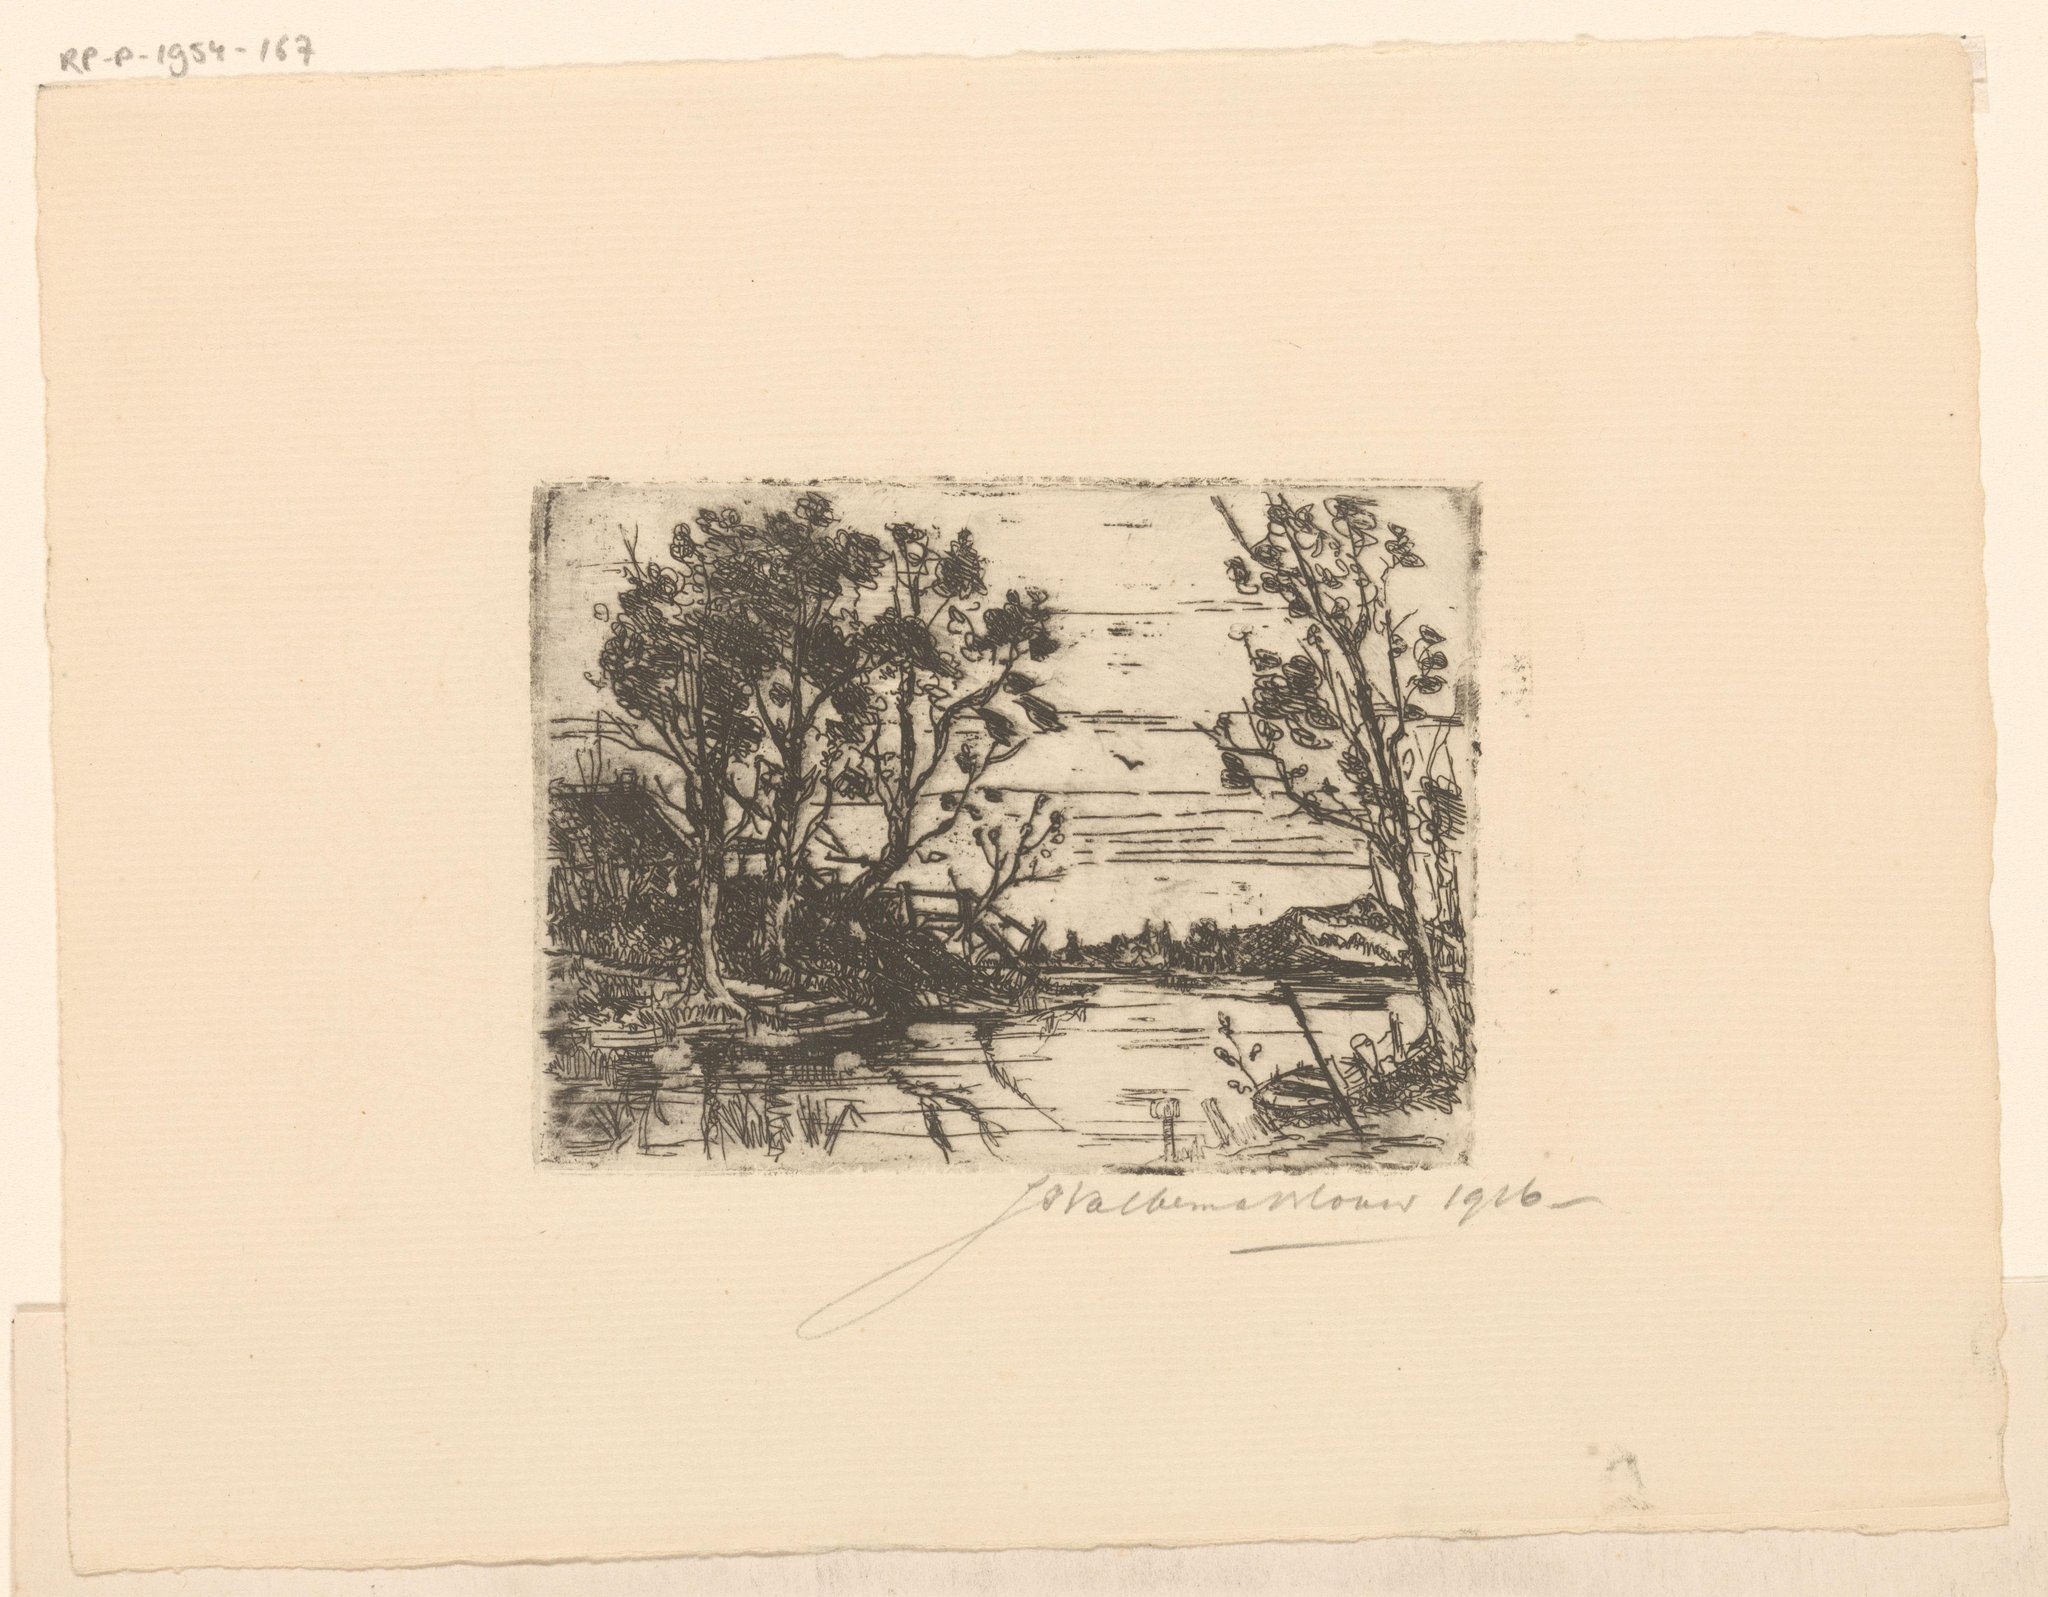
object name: print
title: Vaart met boerderij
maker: jan paul valkema blouw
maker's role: draughtsman, print maker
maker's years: 1884-1954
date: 1916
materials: paper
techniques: etching, intaglio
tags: canal, farm or solitary house in landscape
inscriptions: collector's mark: Lugt 2760, collector's mark: Lugt 2228